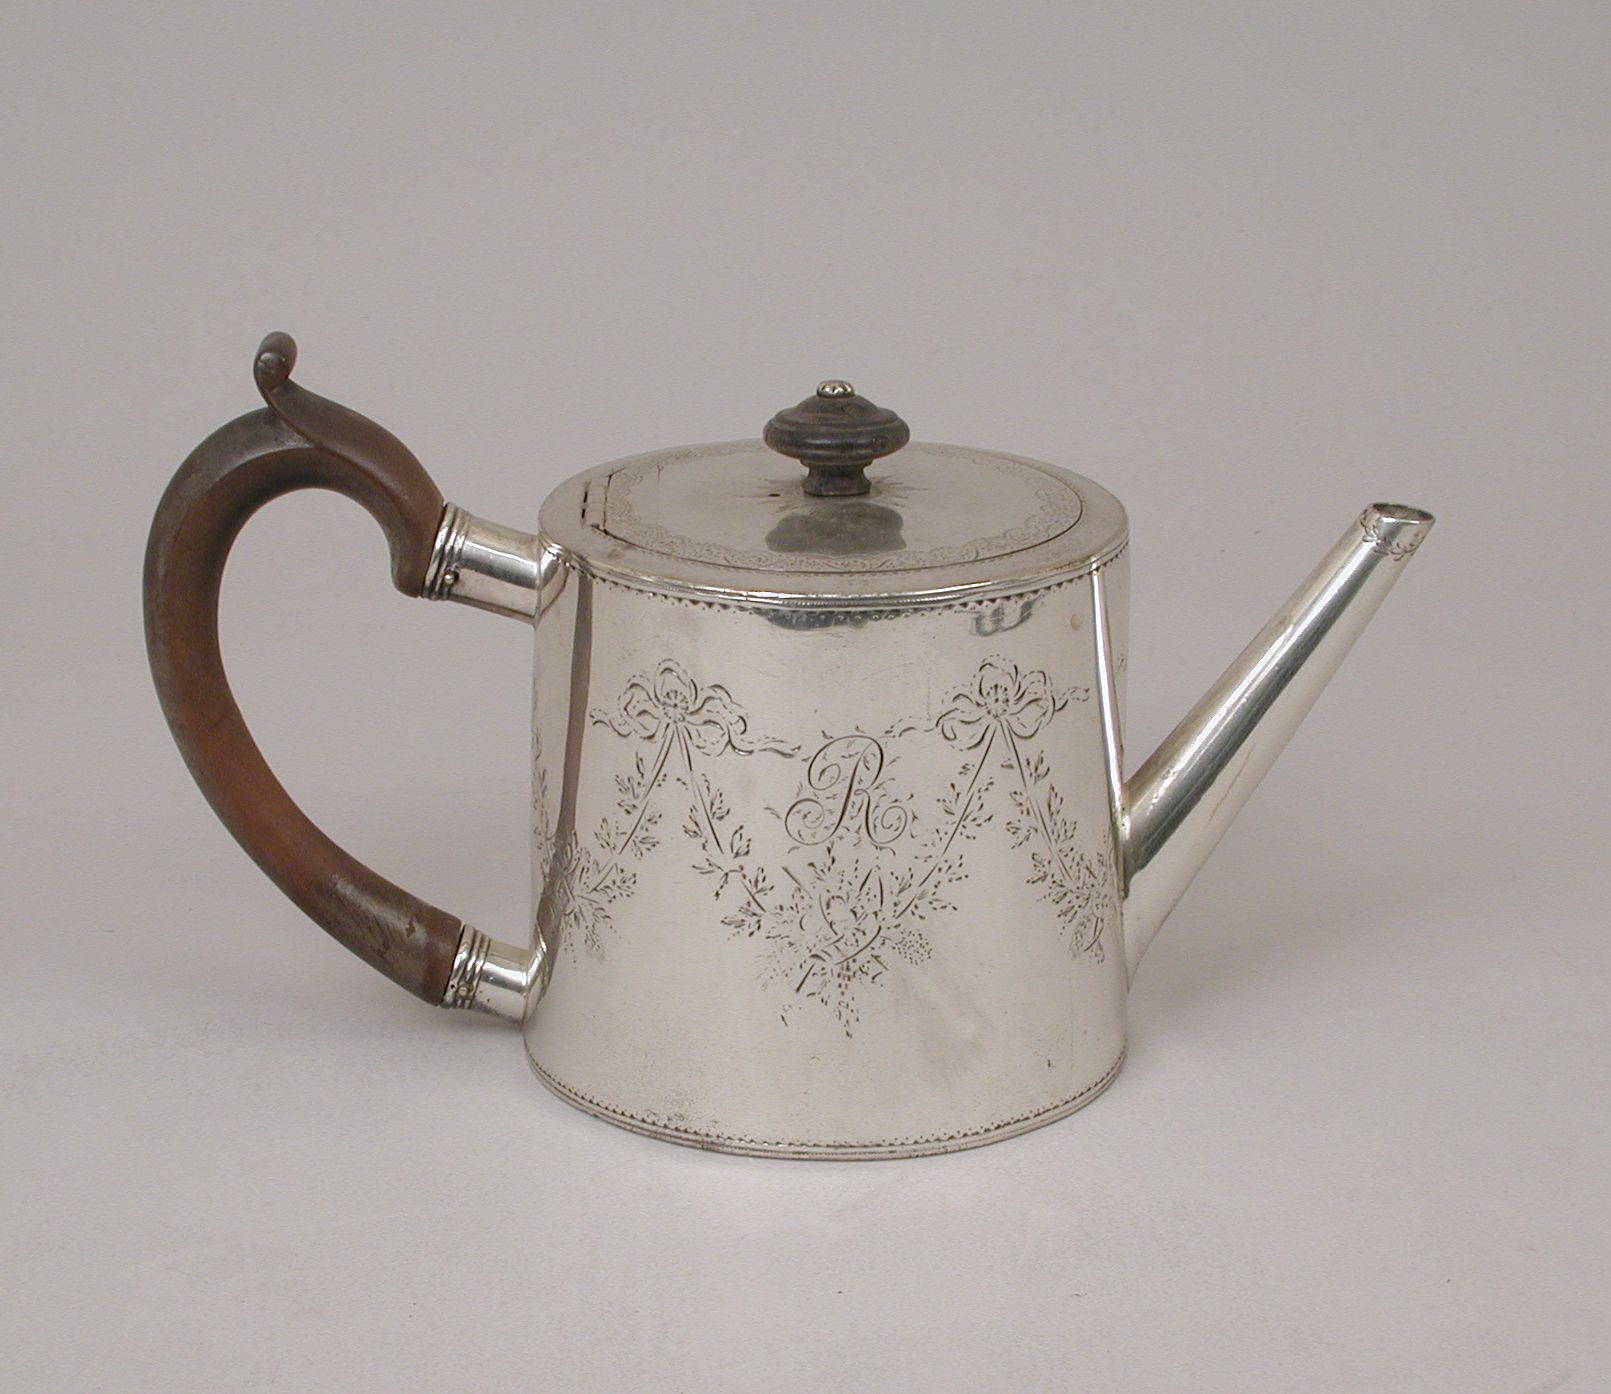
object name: teapot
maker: a. l.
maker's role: maker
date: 1767-1800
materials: silver